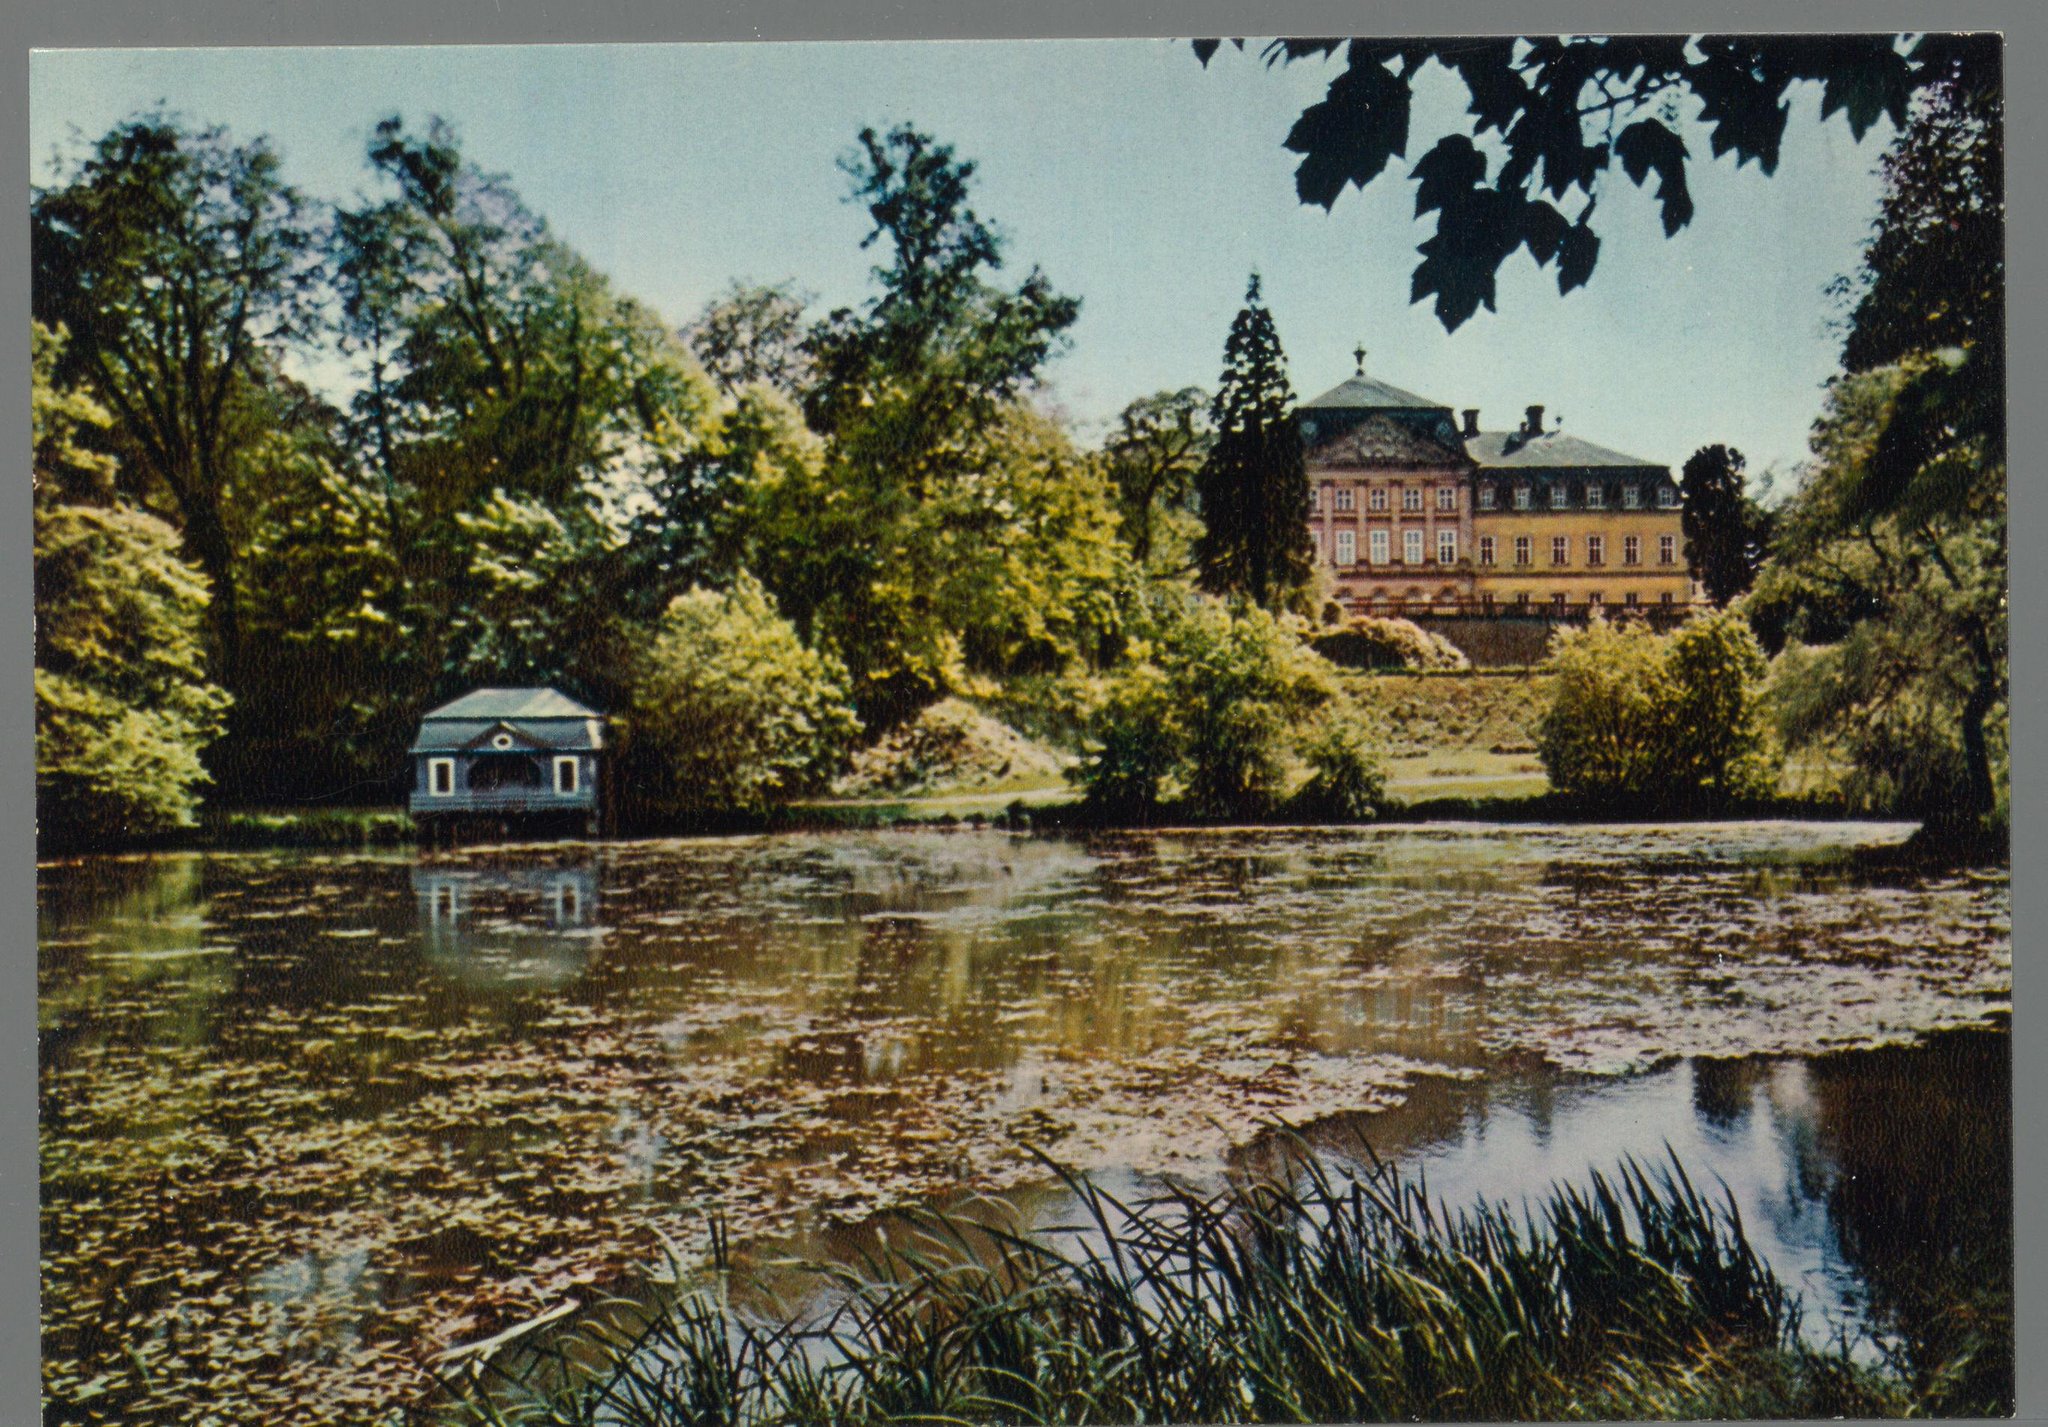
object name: ansichtkaart, prentbriefkaart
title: Luftkurort Arolsen (Waldeck). Residenzschloss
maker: Anonymous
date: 1905-1976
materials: cardboard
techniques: four-color rotogravure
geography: bad arolsen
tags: castle, watering-place, spa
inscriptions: date